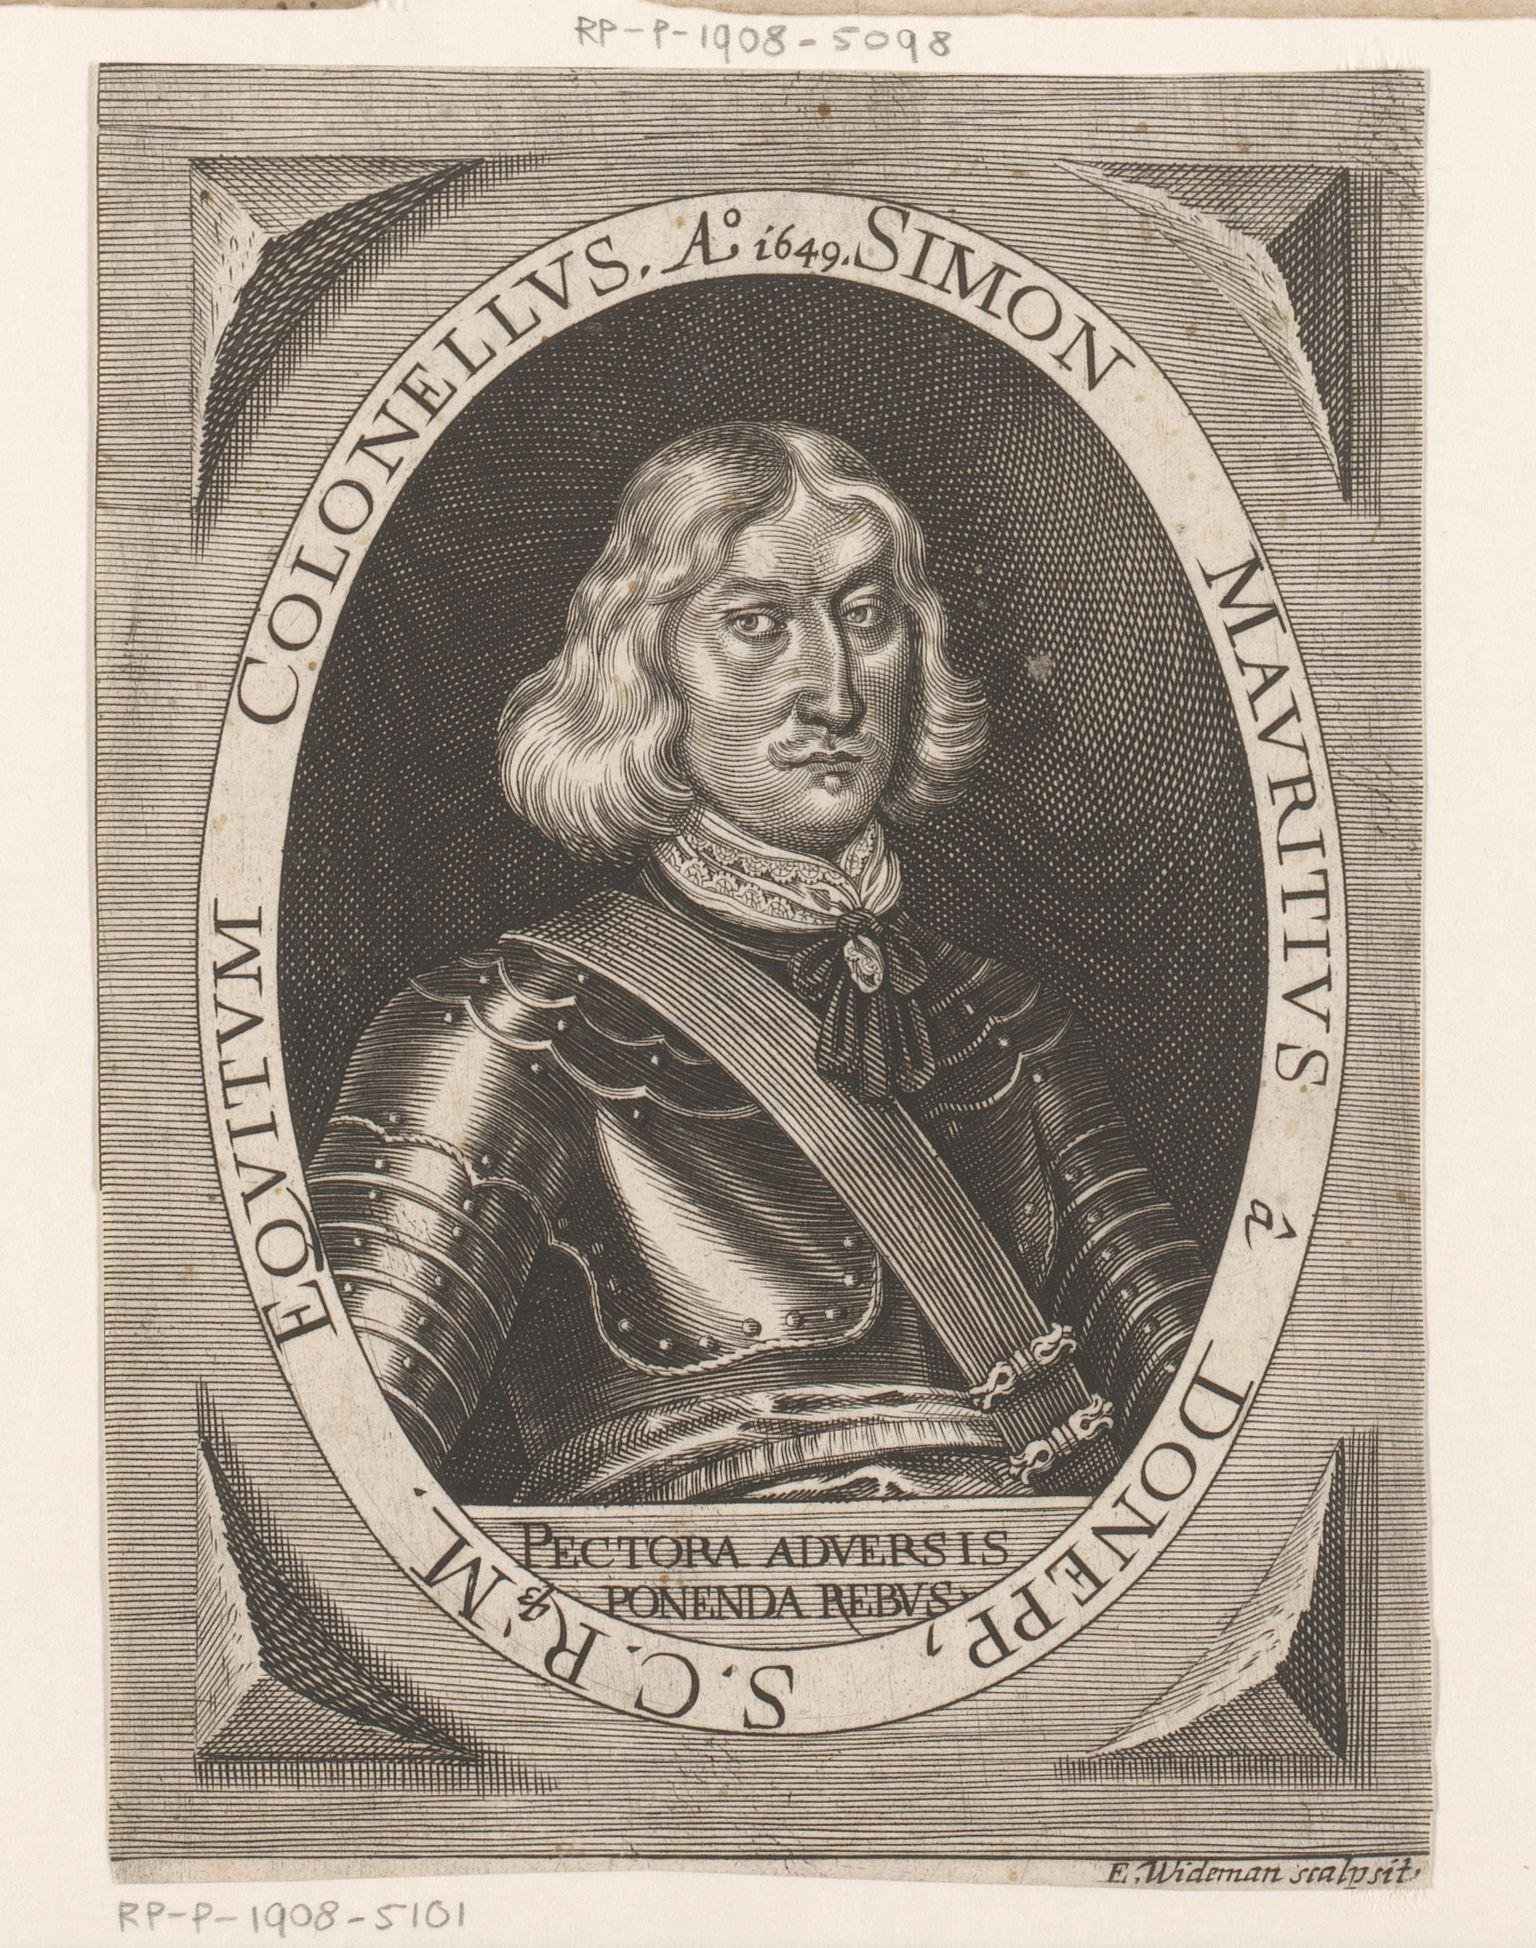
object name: print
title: Portret van Simon Moritz von Donepp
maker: elias widemann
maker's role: print maker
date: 1649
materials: paper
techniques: engraving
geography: vienna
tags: historical persons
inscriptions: collector's mark: Lugt 2228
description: Prent uit de publicatie: Widemann, Elias. Honori Sacrum. Wenen: s.n., 1649.